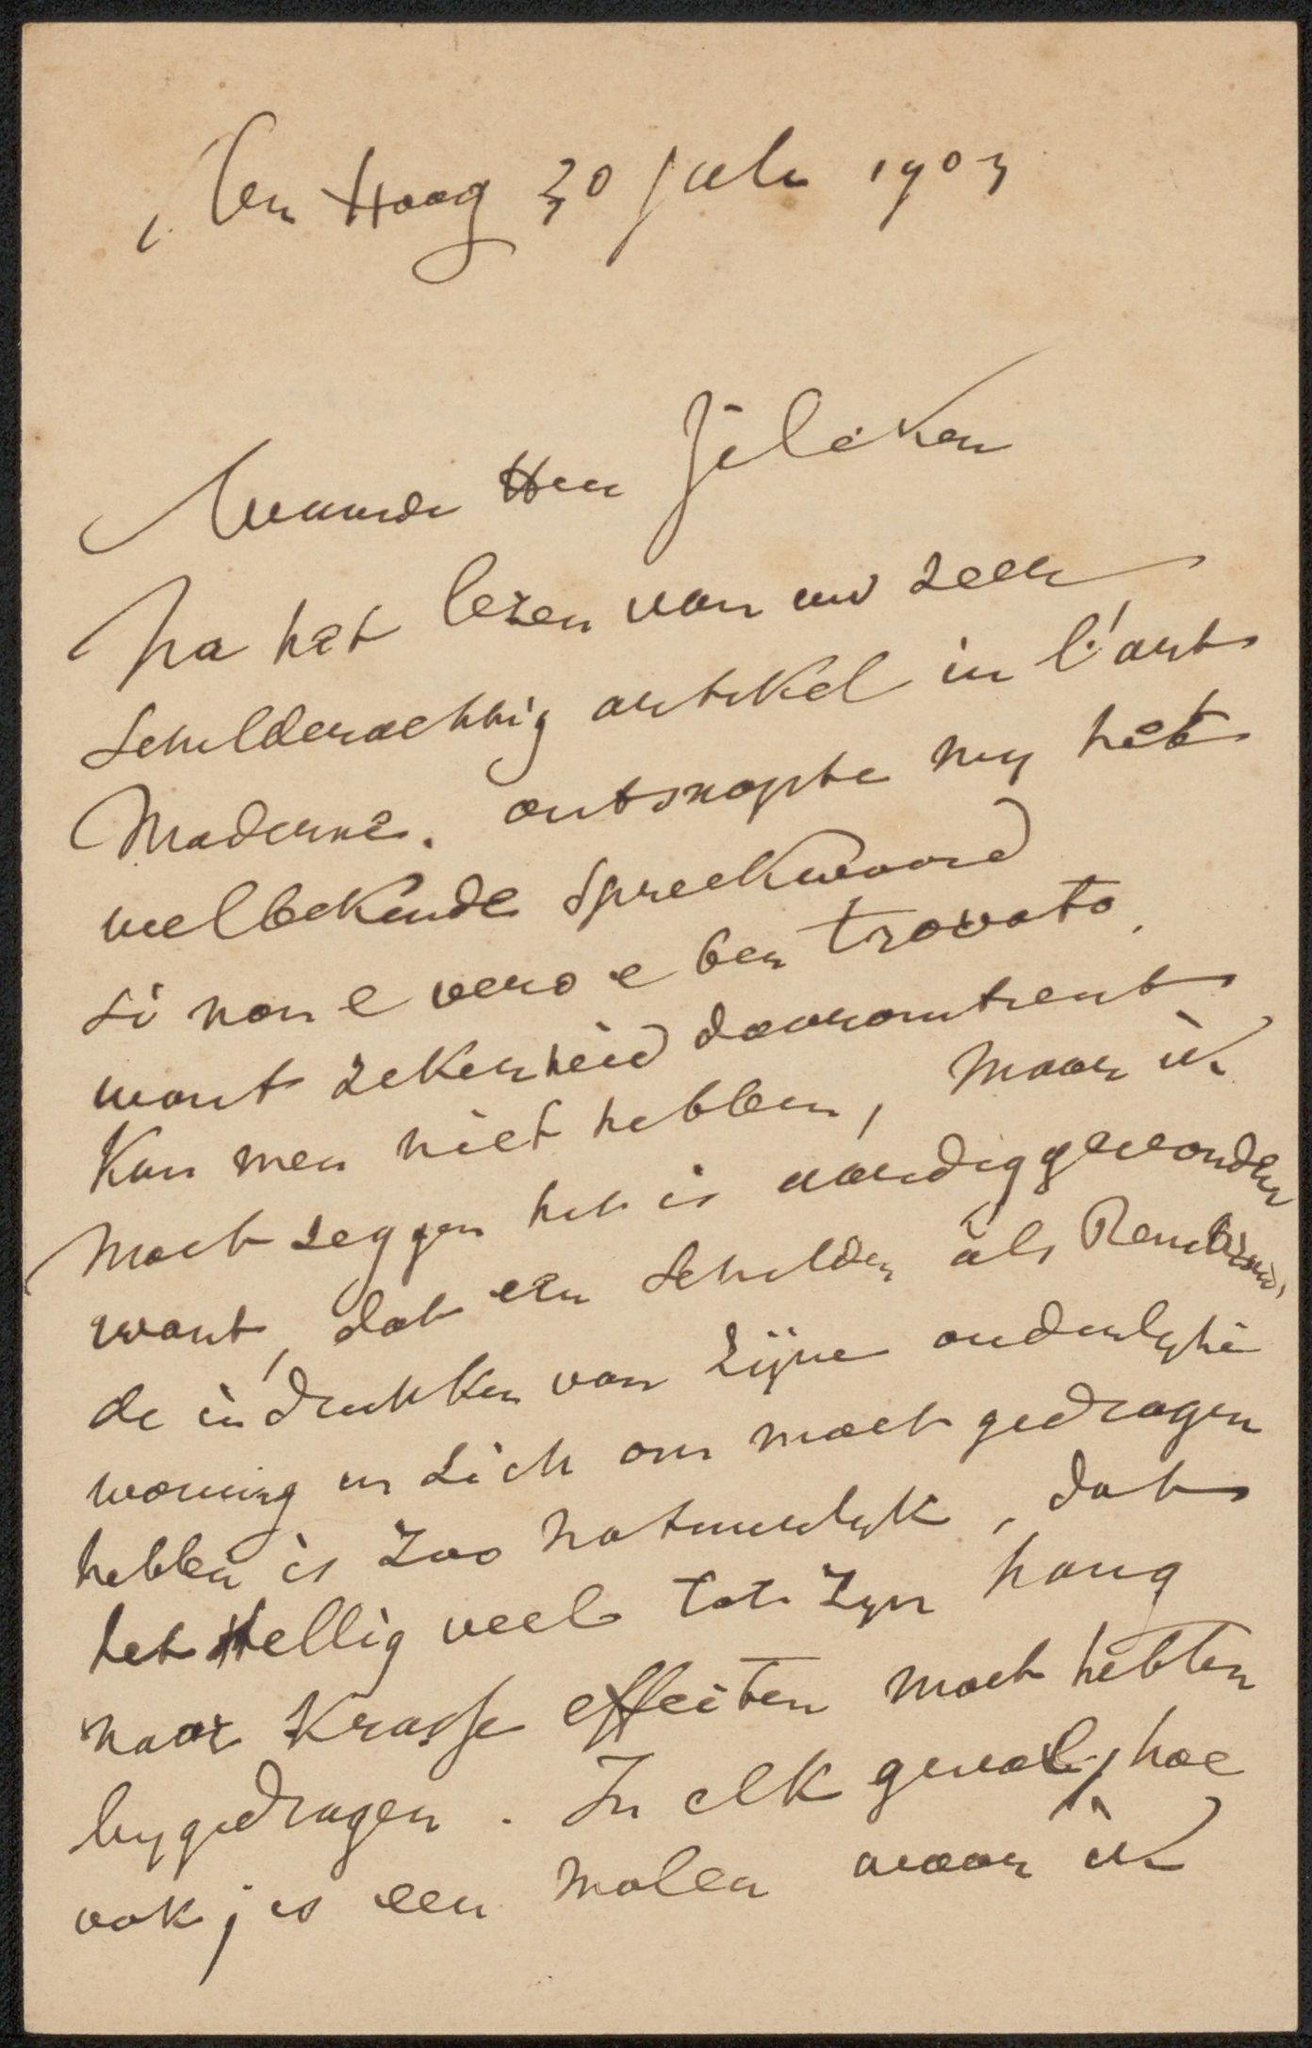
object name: letter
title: Brief aan Philip Zilcken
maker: jozef israëls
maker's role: draughtsman, painter, print maker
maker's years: 1824-1911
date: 1903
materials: ink, paper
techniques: pen, writing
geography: the hague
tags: amsterdam, print maker, draughtsman, hendrik adriaan christiaan dekker, leiden, rembrandt van rijn, philip zilcken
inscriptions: collector's mark: ‘RPK’